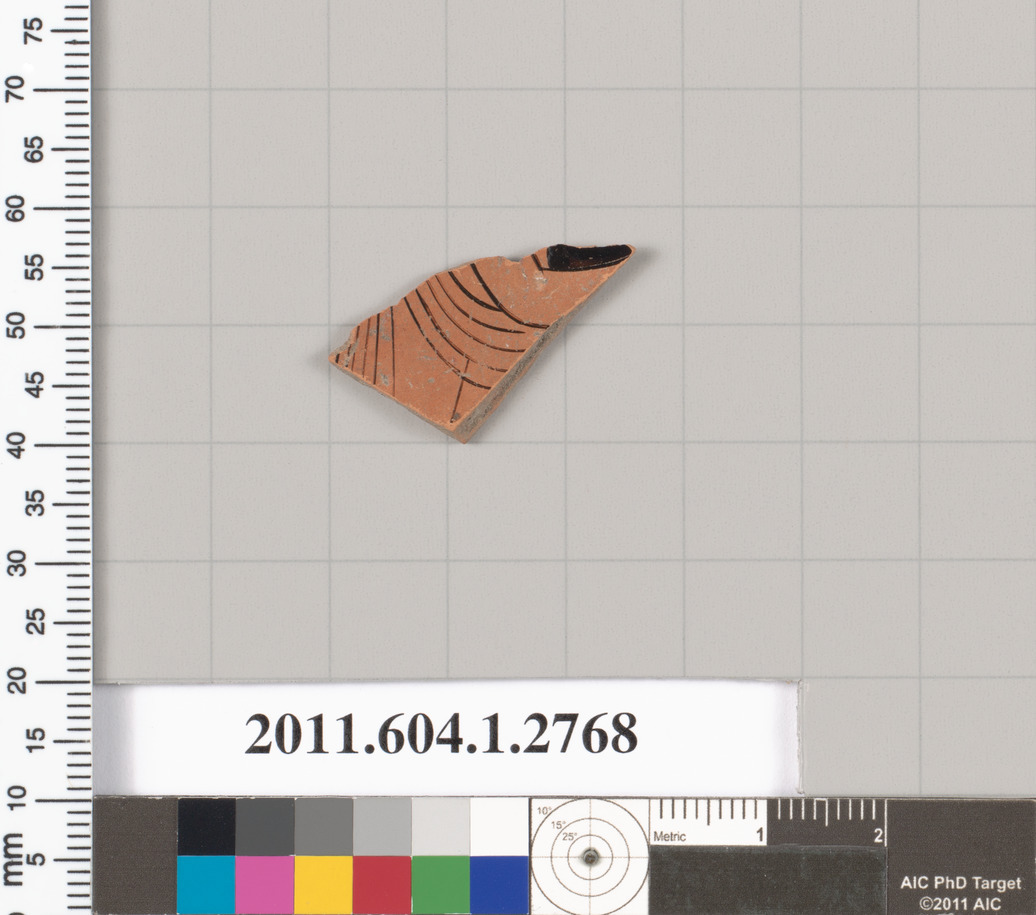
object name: kylix fragment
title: Terracotta fragment of a kylix (drinking cup)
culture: greek, attic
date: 475-451 BCE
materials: terracotta